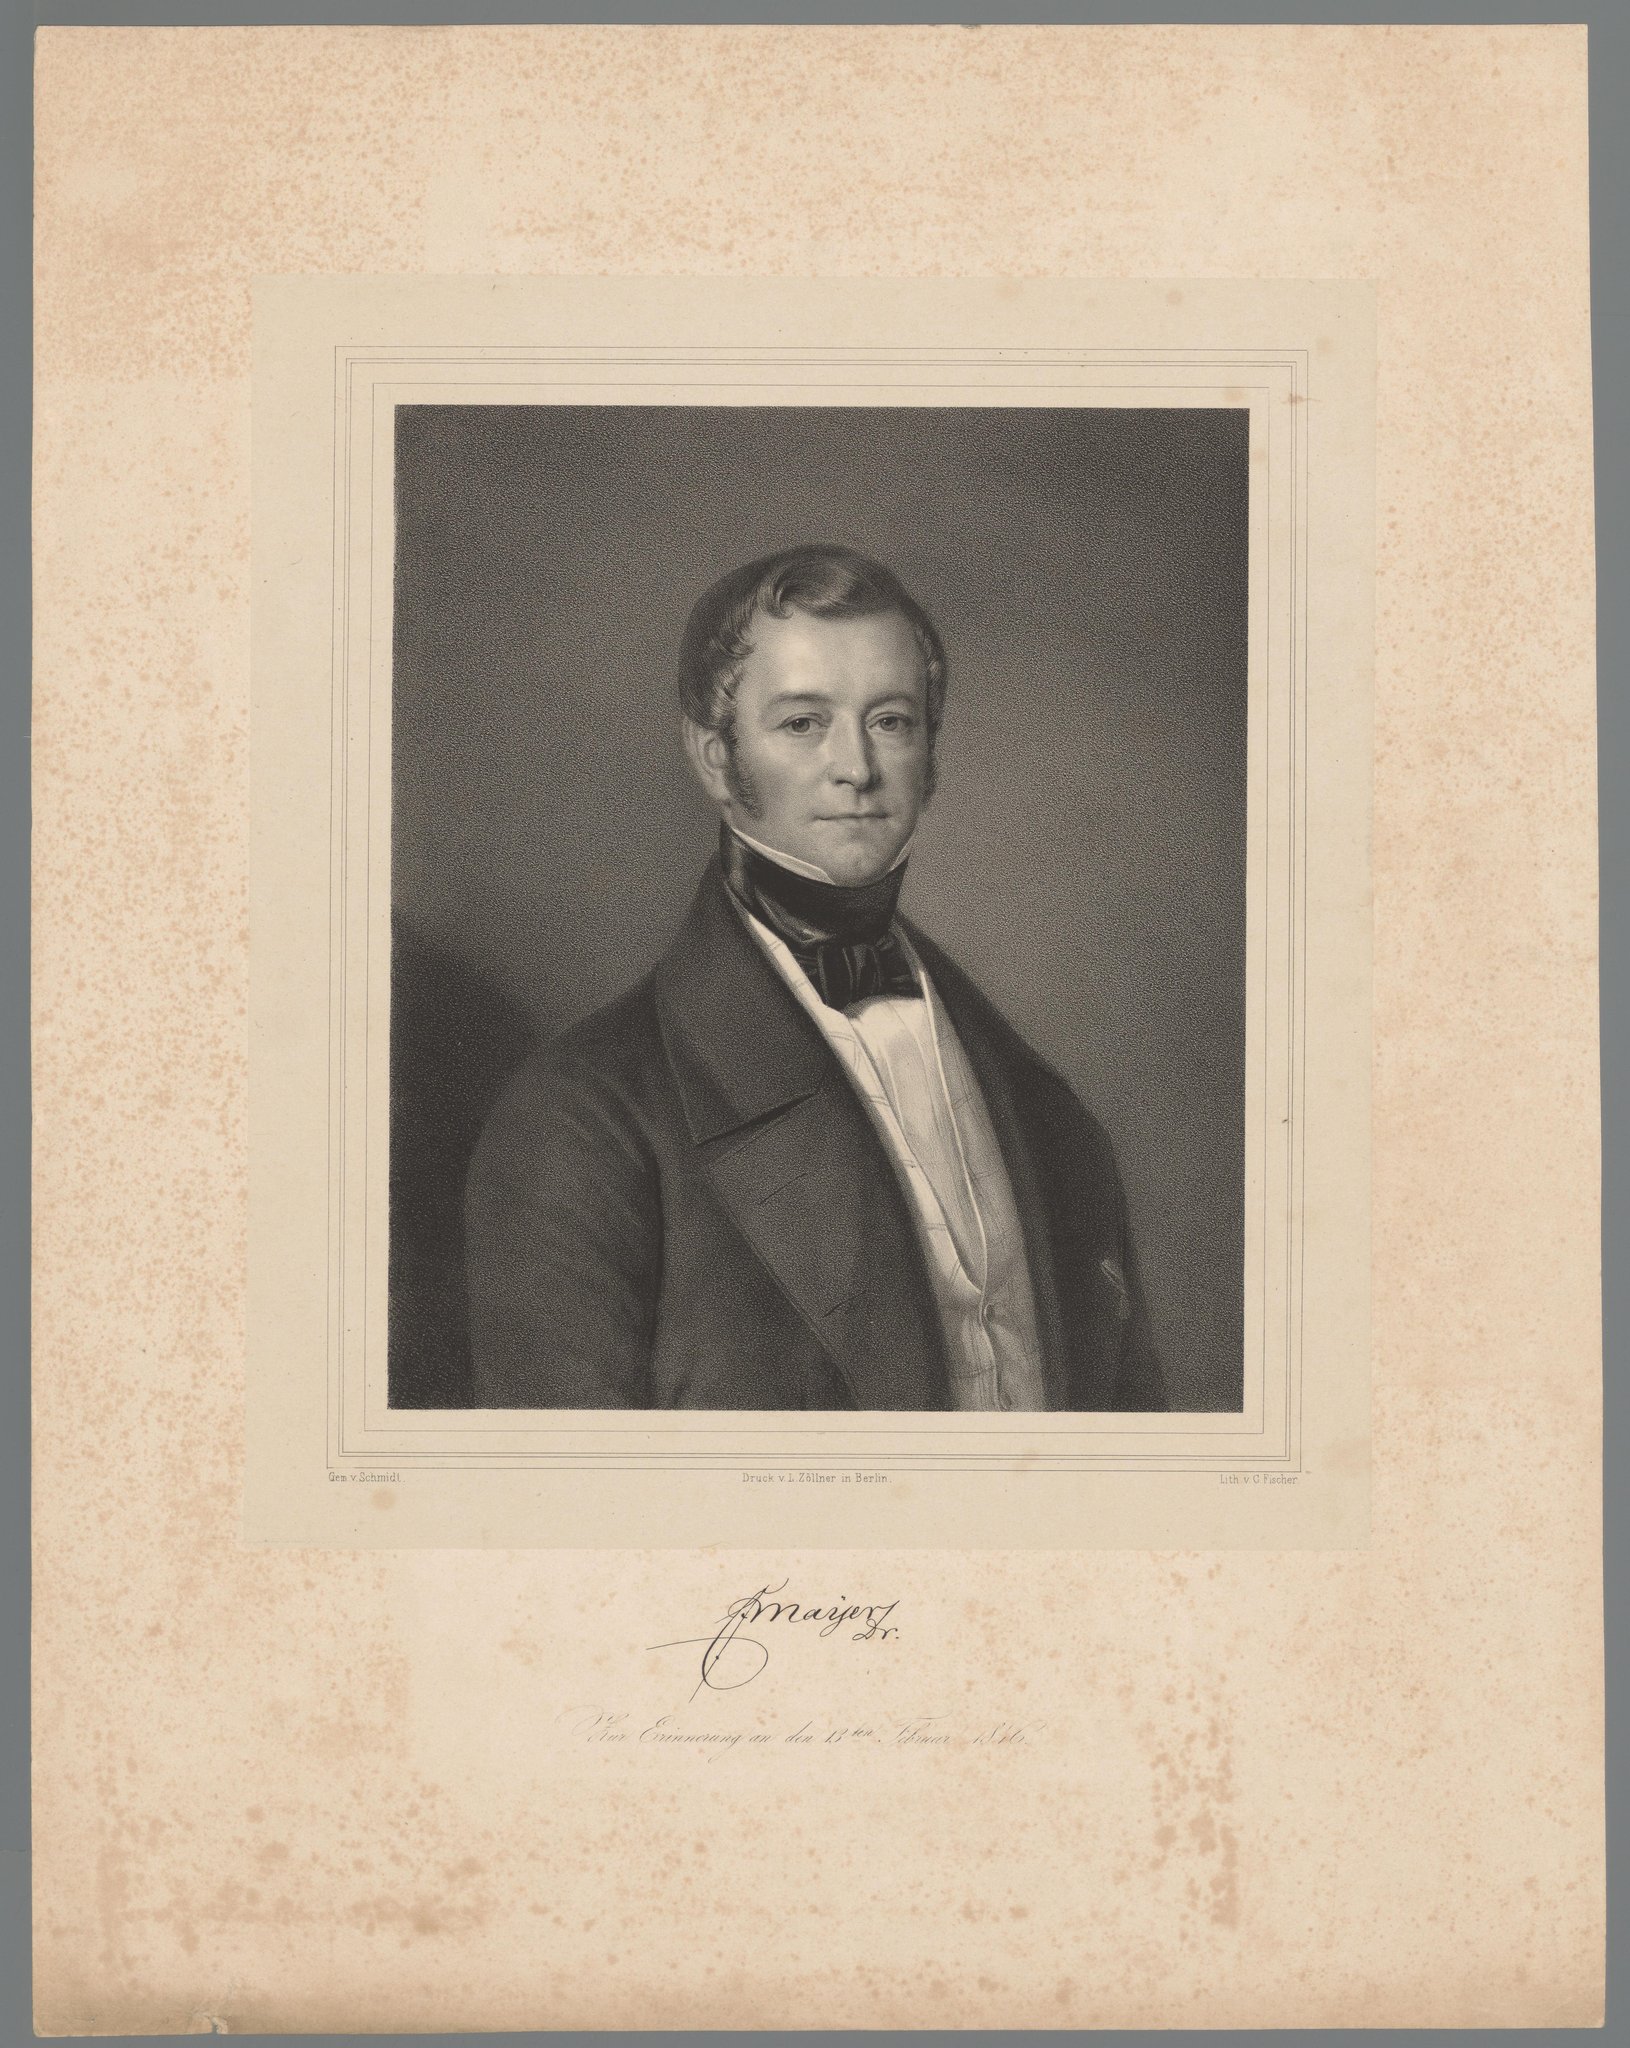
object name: print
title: Portret van een onbekende man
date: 1846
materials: paper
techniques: lithograph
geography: berlin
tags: historical persons not known by name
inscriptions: collector's mark: Lugt 2228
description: Portret van een verder onbekende man, met handtekening in facsimile waarin de naam F. Mayer, Dr. te lezen is.